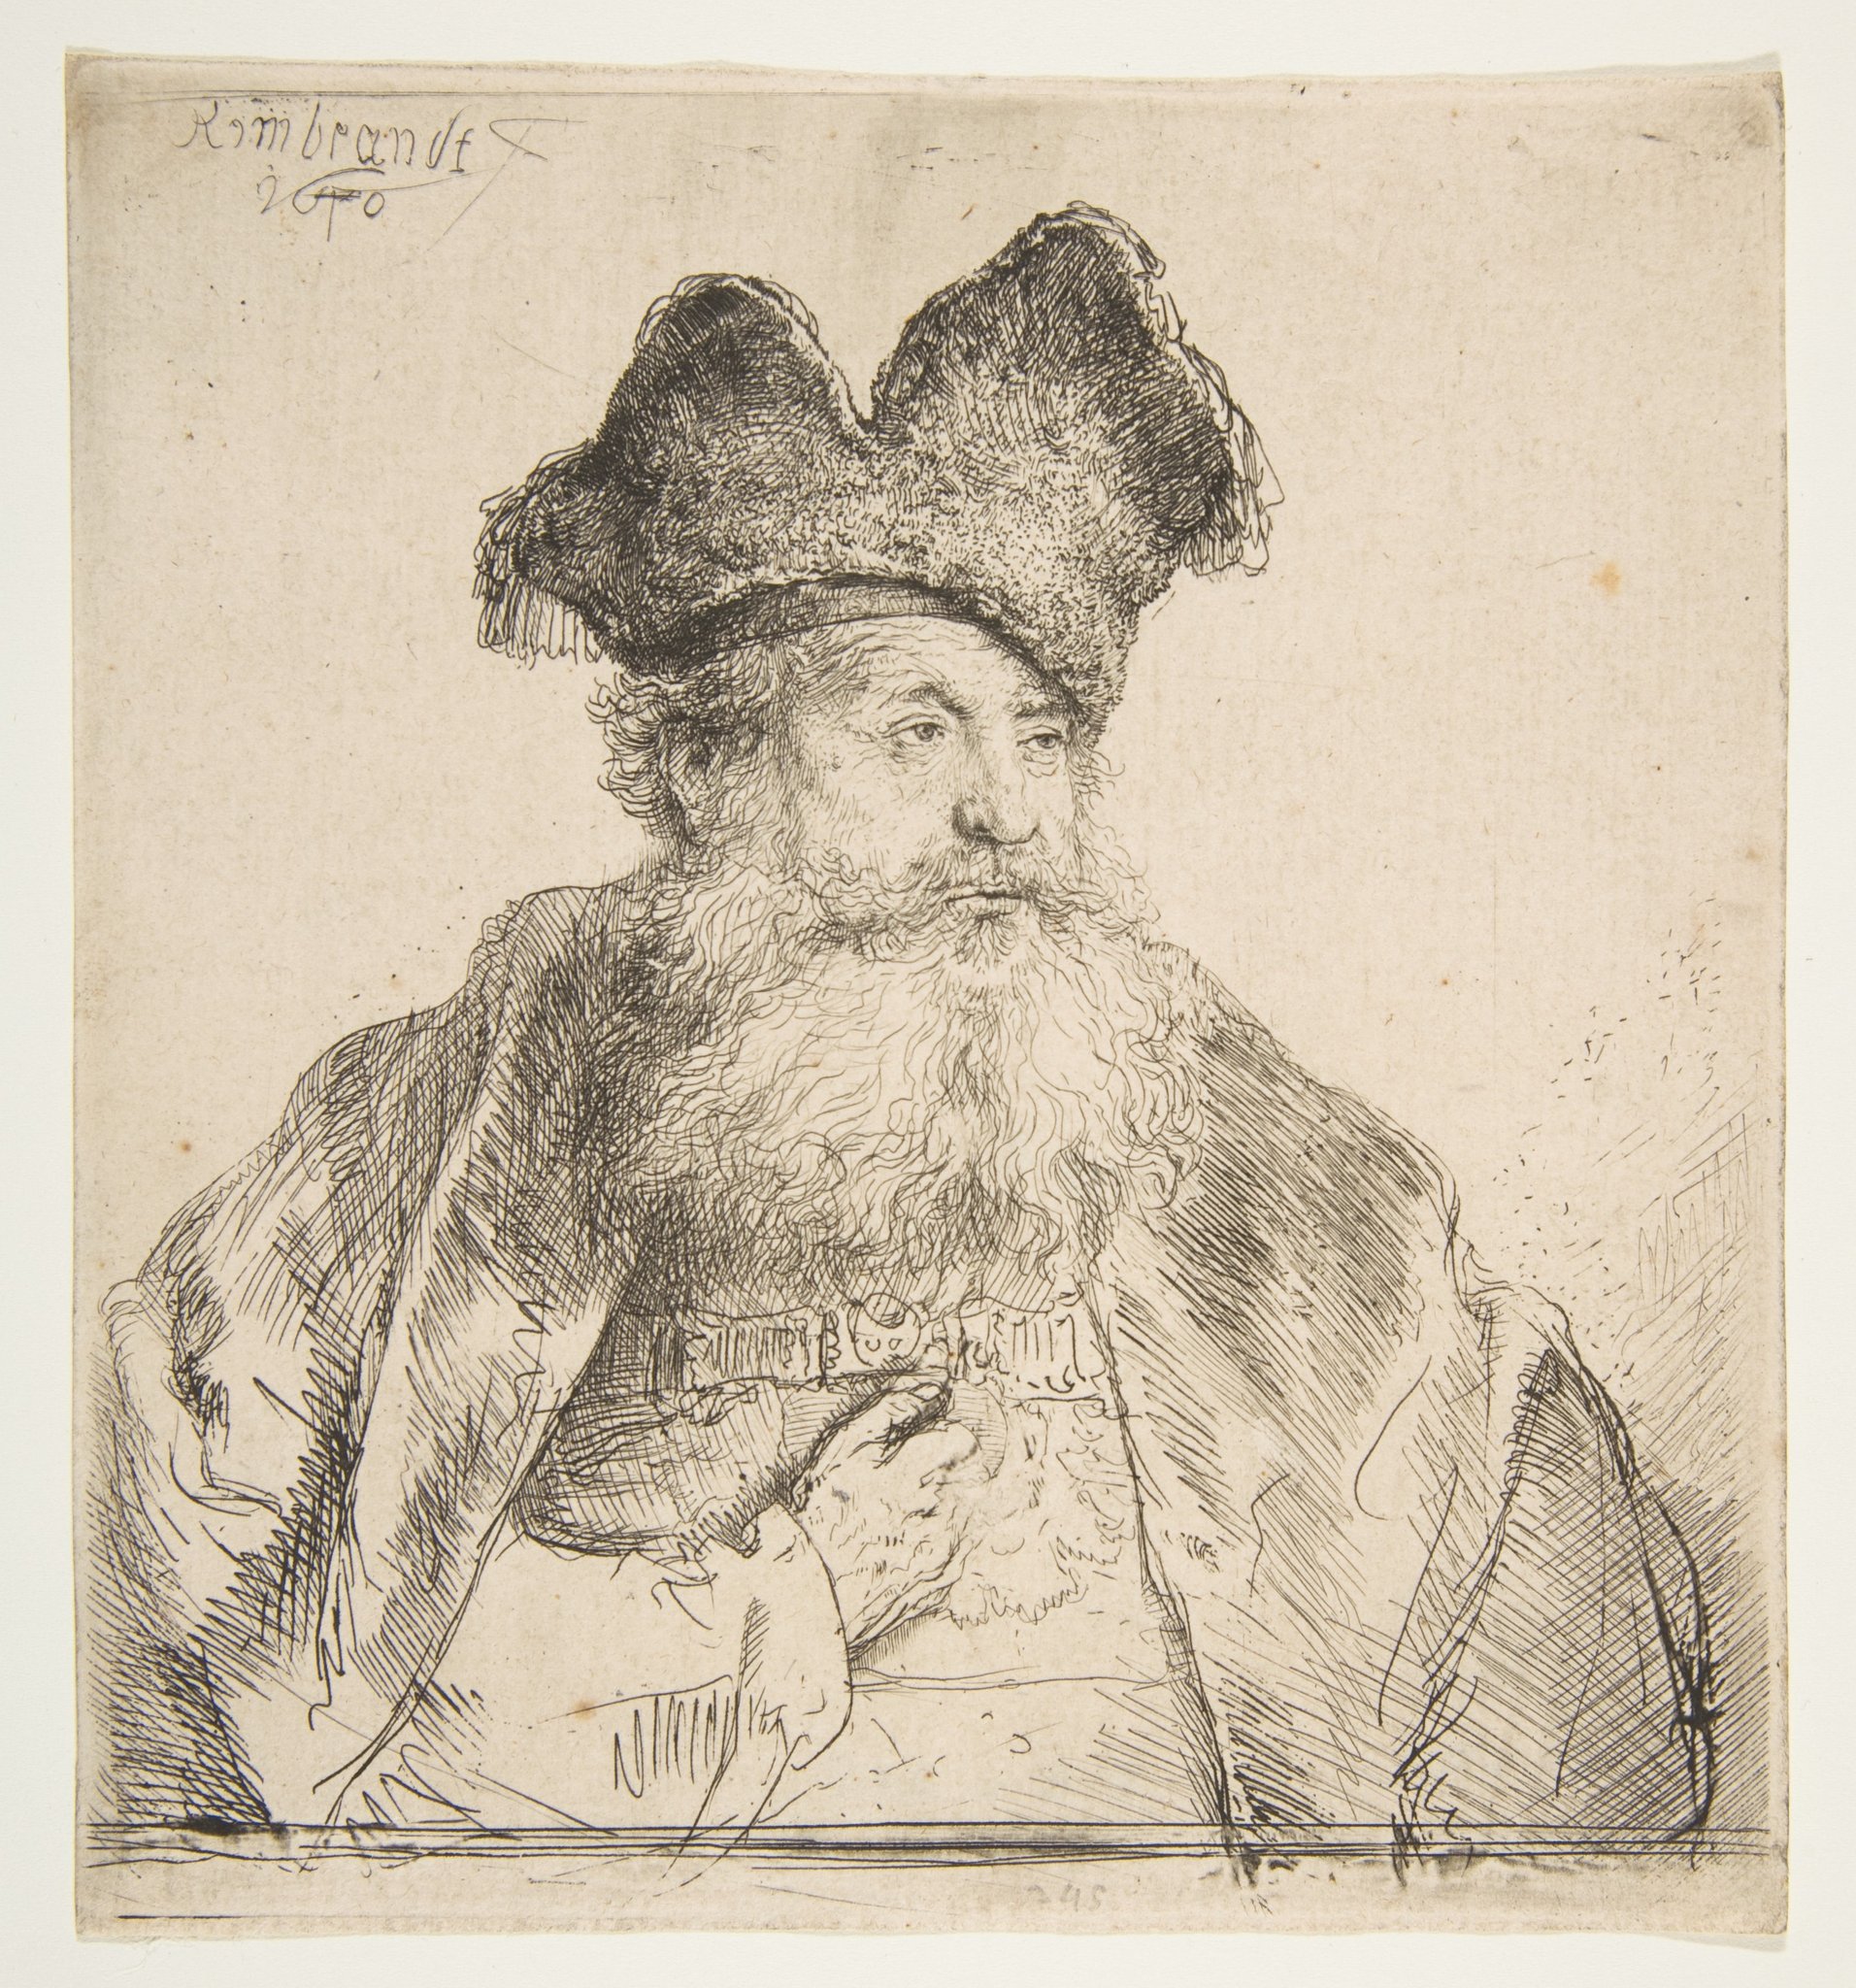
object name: print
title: Old Man with a Divided Fur Cap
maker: rembrandt van rijn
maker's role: artist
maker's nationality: dutch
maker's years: 1606-1669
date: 1634-1644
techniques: etching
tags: hats,men,portraits